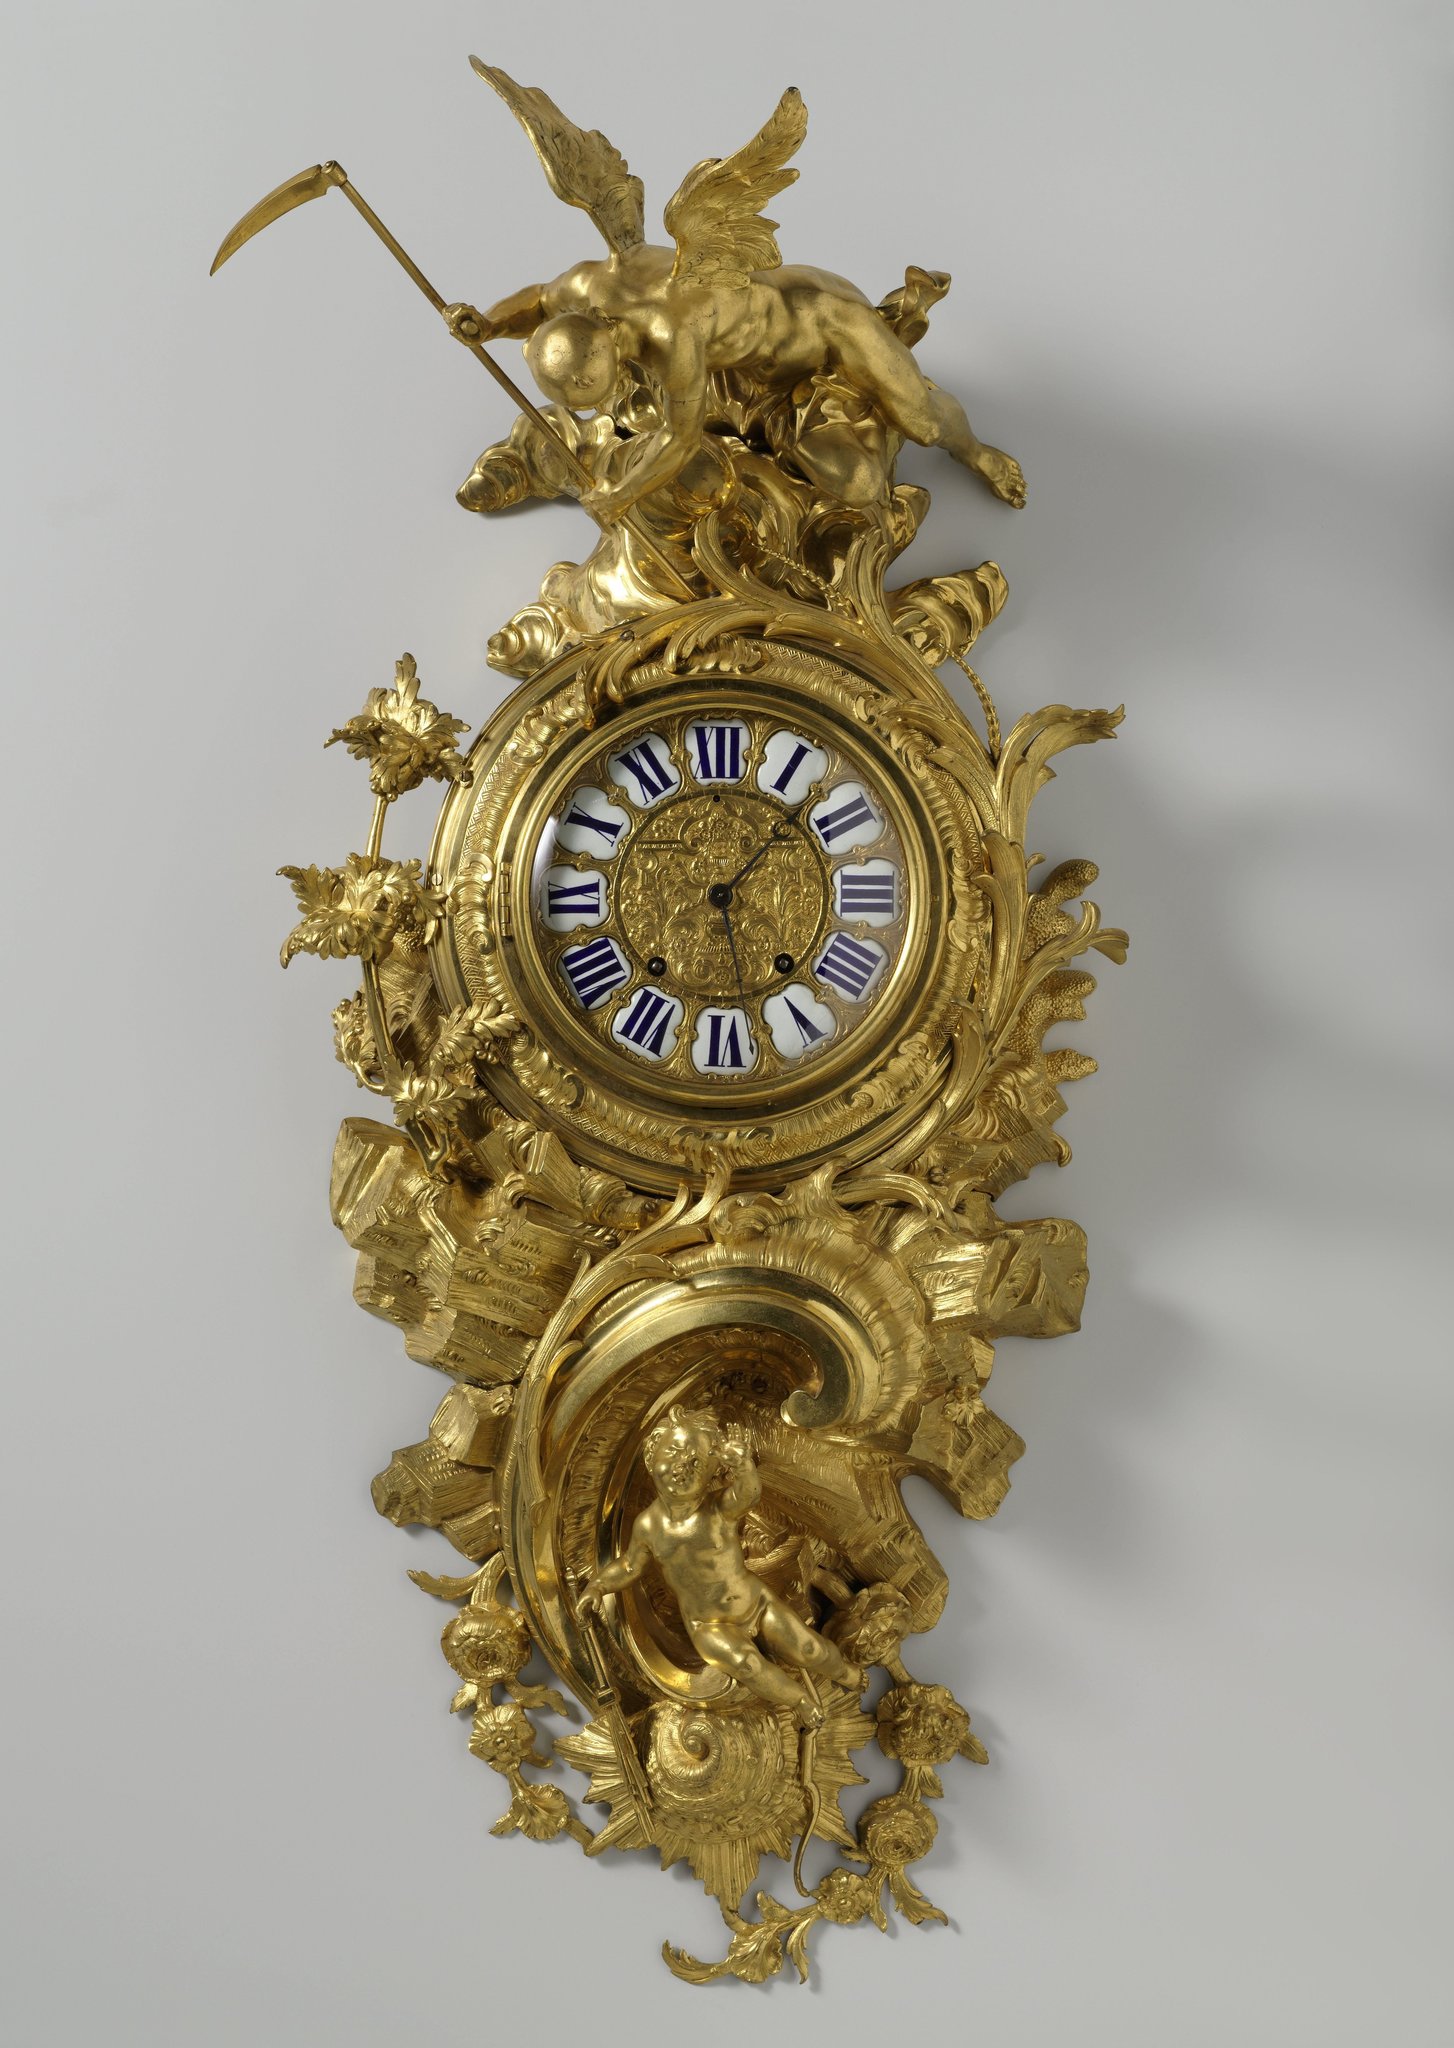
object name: furniture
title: Cartel clock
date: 1740-1745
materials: brass, bronze, wood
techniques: gilding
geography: paris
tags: (story of) cupid, amor (eros), father time, man with wings and scythe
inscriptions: signature and date: ‘Richard 1756’, signature: ‘hervé a paris’, inscription: ‘A. Ruplin/ Besançon/ 12-4-1901’, inscription: ‘Baster’, signature: ‘Hervé AParis’, inscription: ‘12-1-1942/ A. van Gelder/ Wessing/ MULDER’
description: The famous Paris cabinetmaker Cressent trained as a sculptor. He excelled in working with gilt bronze. Surmounting this wall clock is the winged figure of Father Time with his scythe, threatening to cut the thread of life of Cupid, the god of love, who drops his bow and arrow in fear. Cressent created an asymmetrical Rococo composition, built up of a large scroll and motifs derived from nature.